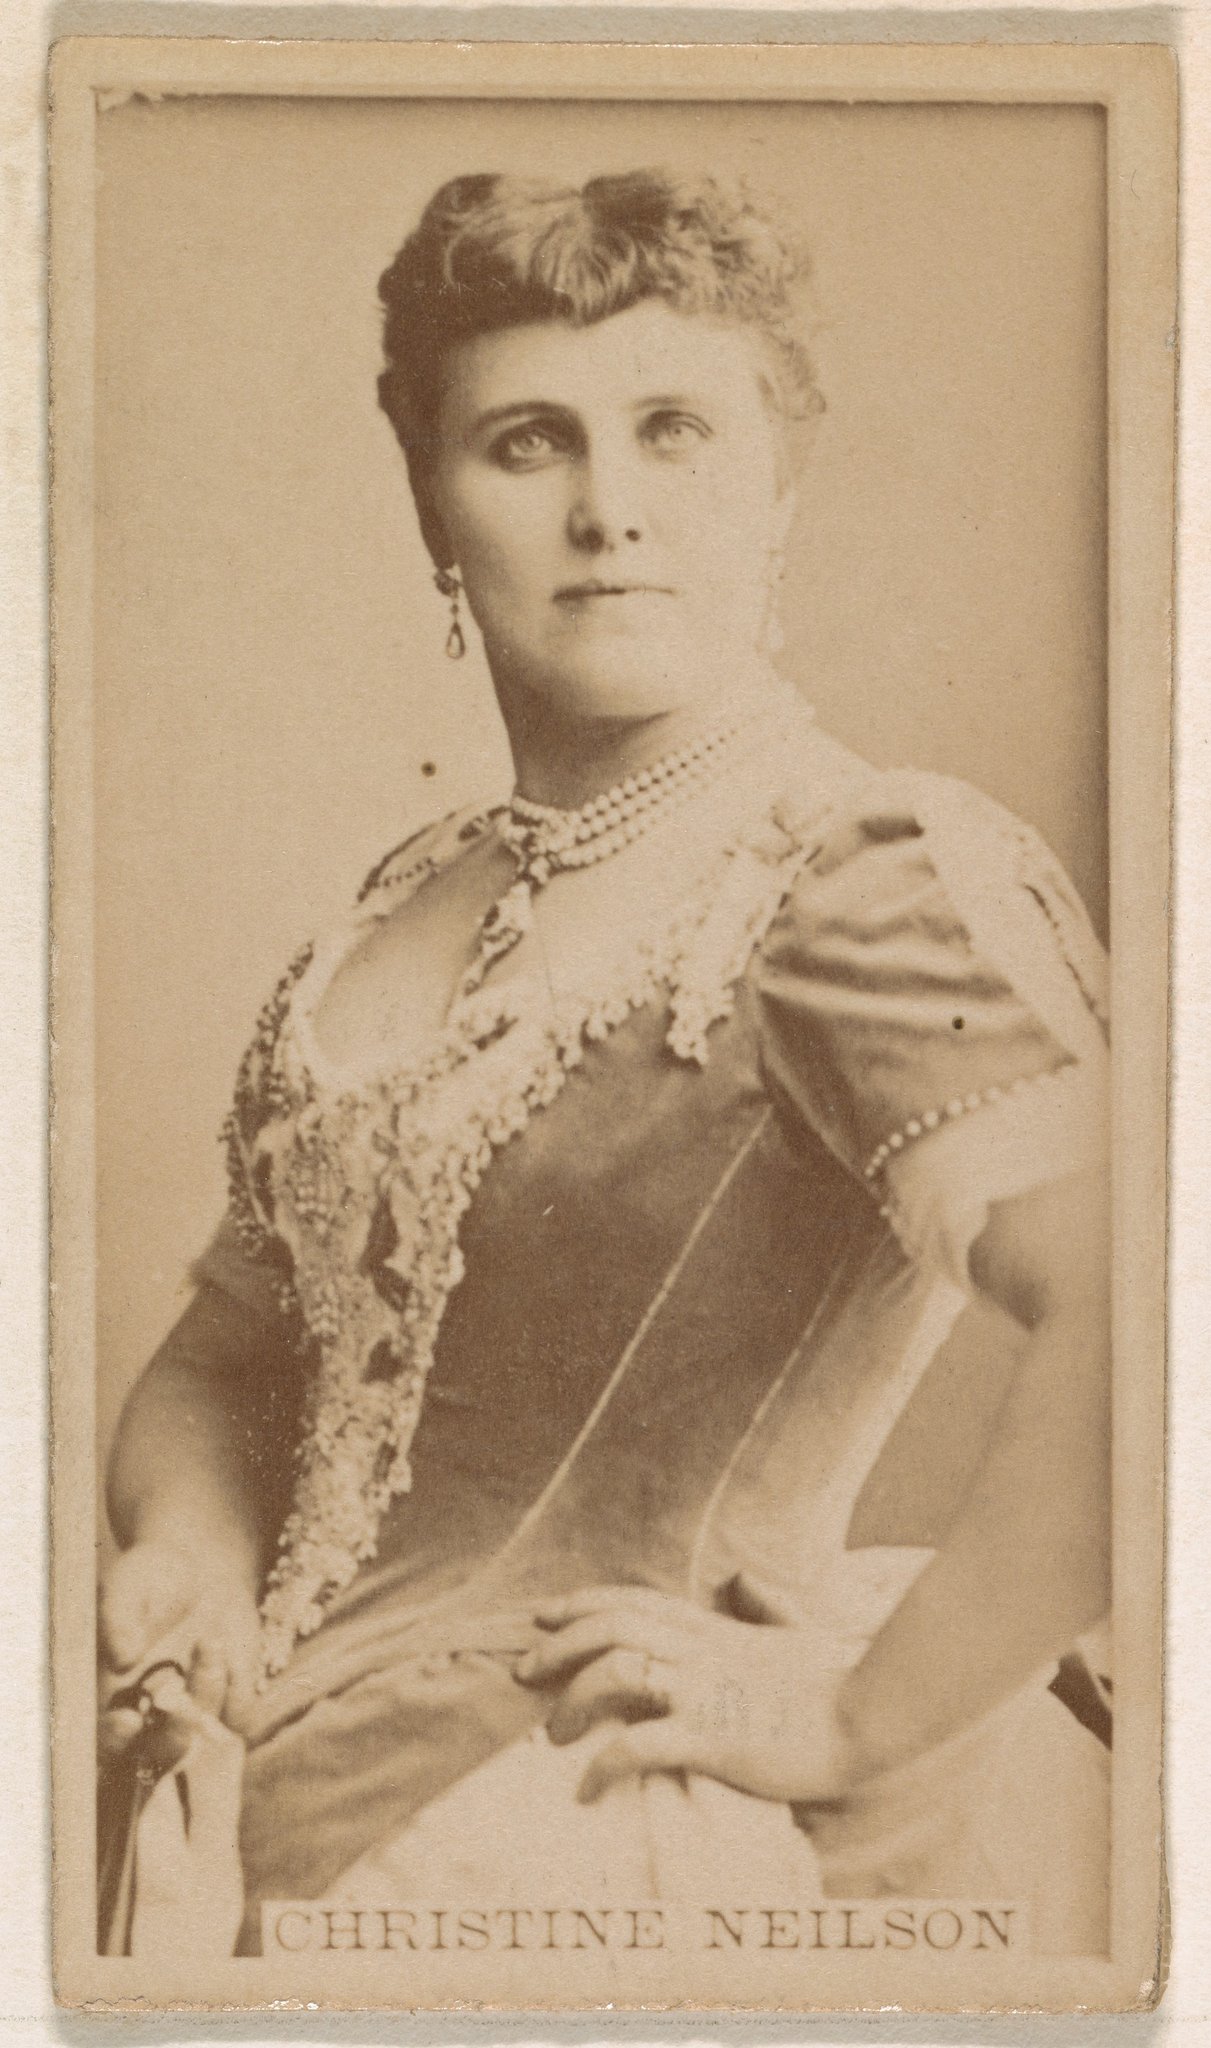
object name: photograph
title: Christine Neilson, from the Actresses series (N245) issued by Kinney Brothers to promote Sweet Caporal Cigarettes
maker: kinney brothers tobacco company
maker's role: publisher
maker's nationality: american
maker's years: 1869-2011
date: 1890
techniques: albumen silver print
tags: portraits,women,actresses